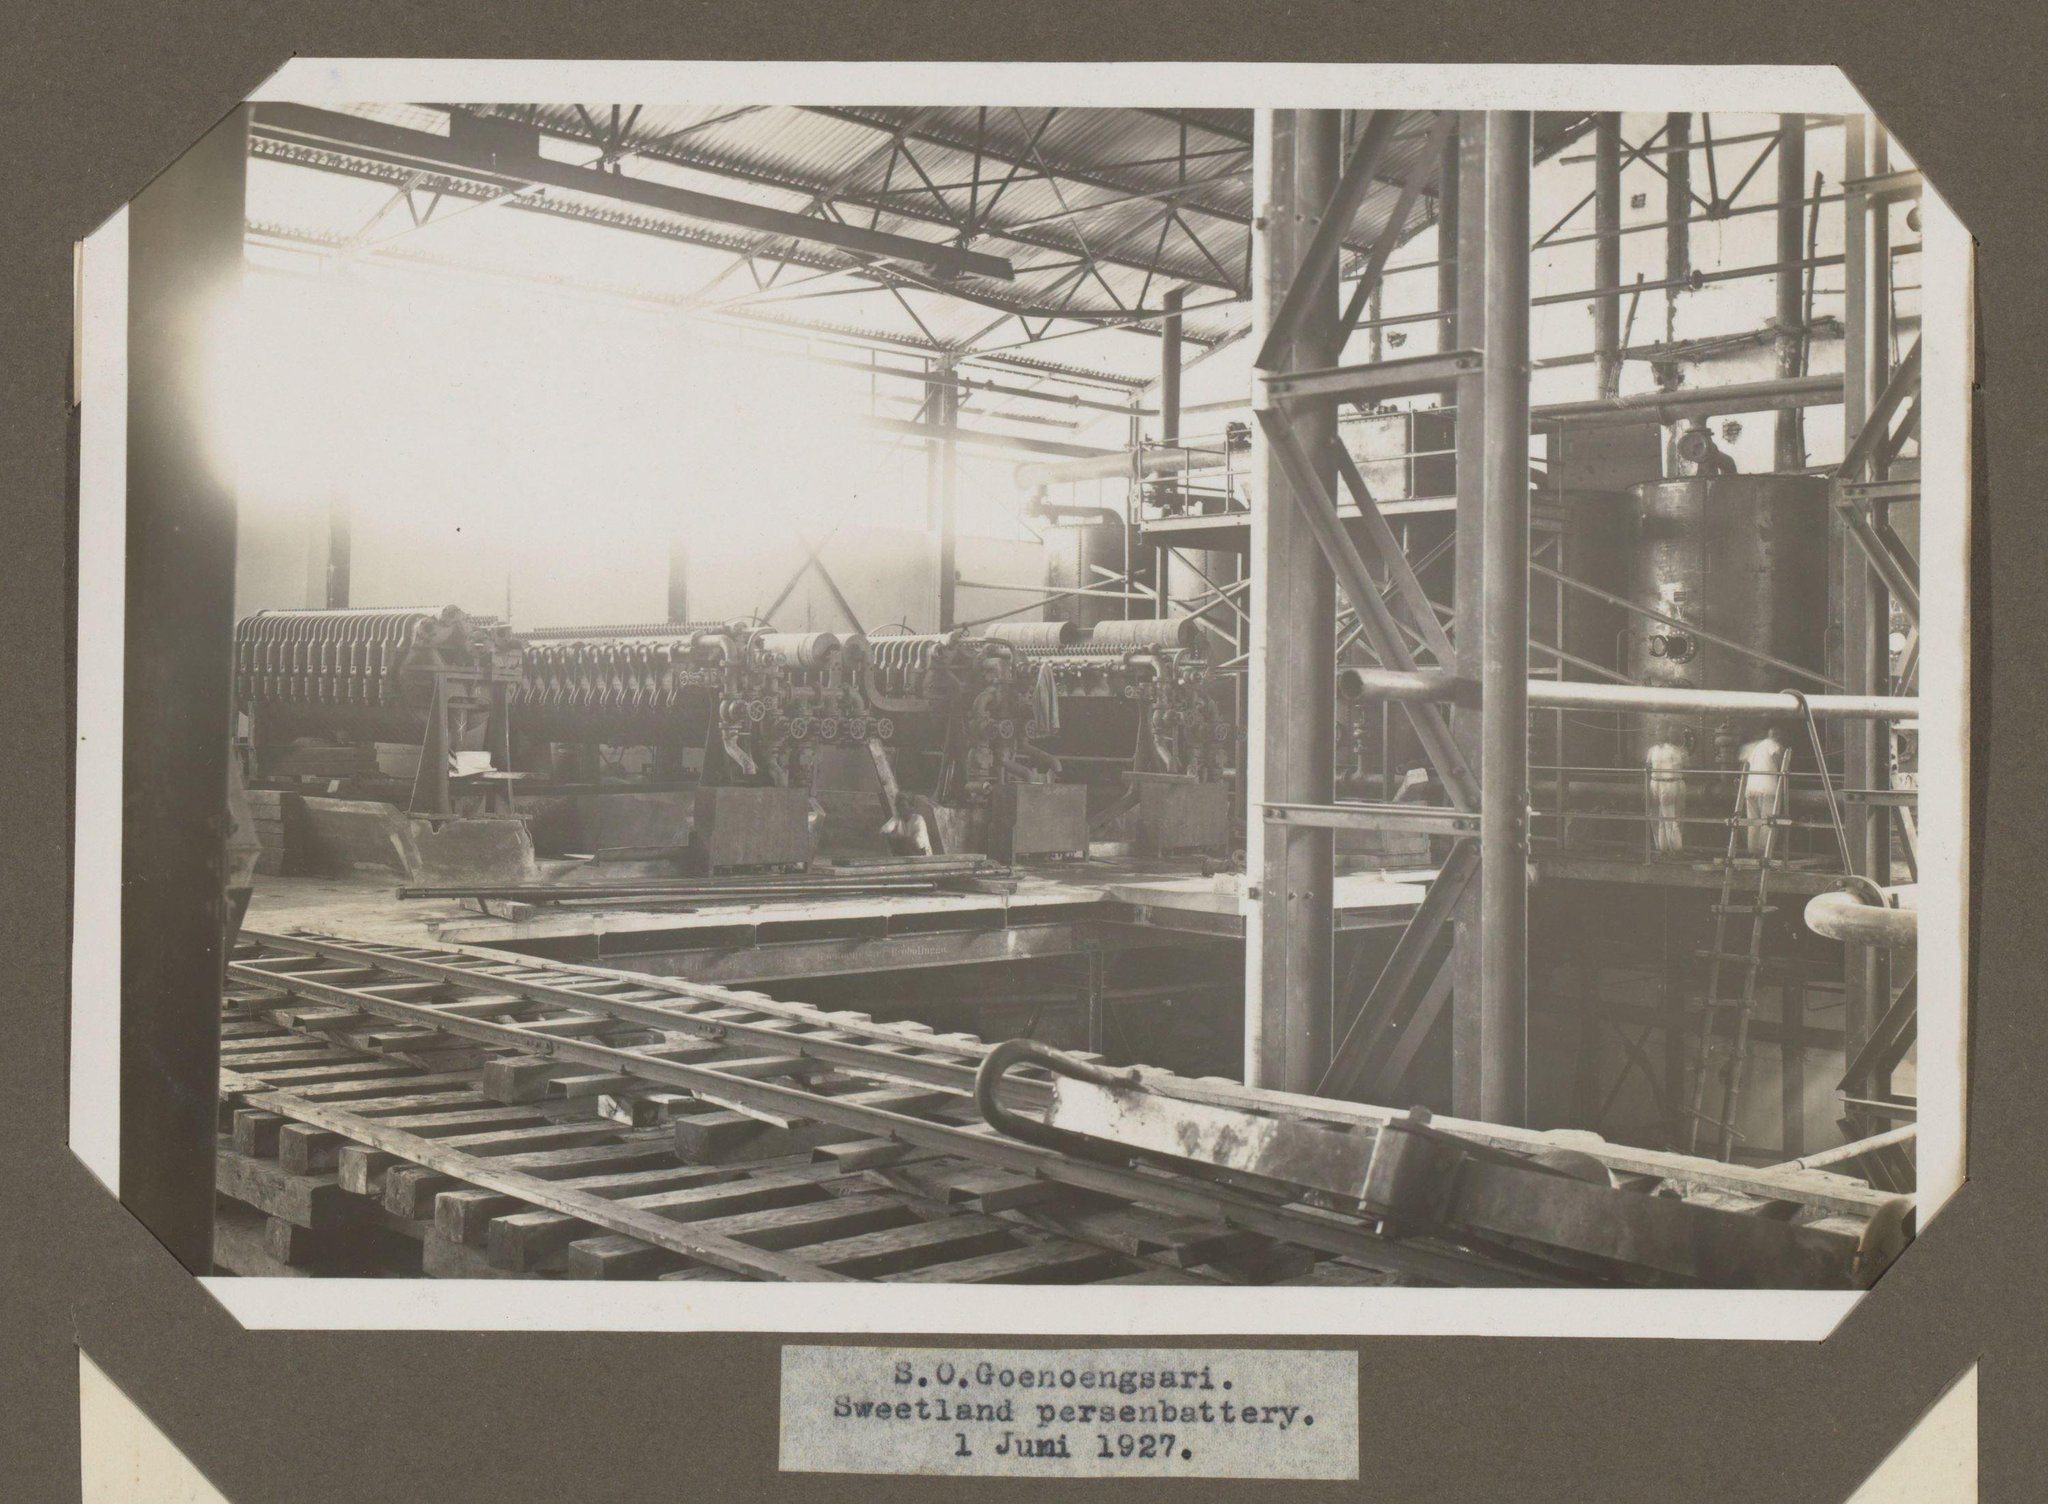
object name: photograph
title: S.O. Goenoengsari. Sweetland persenbattery. 1 Juni 1927.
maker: Anonymous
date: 1906-1927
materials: photographic support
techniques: gelatin silver print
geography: east java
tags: colonial system, trade-company, factory-interior, machine shop, making the overground structures (~ building activities), (non-fruit) products of plants or trees: sugarcane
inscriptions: inscription: ‘S.O. Goenoengsari. Sweetland persenbattery. 1 Juni 1927.’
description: Interieur van een fabrieksgebouw met geïnstalleerde machines, juni 1927. Onderdeel van het fotoalbum met foto's van de opbouw van de suikerfabriek te Goenoengsari op Oost-Java door de Handels Vereniging Amsterdam 1926-1927.